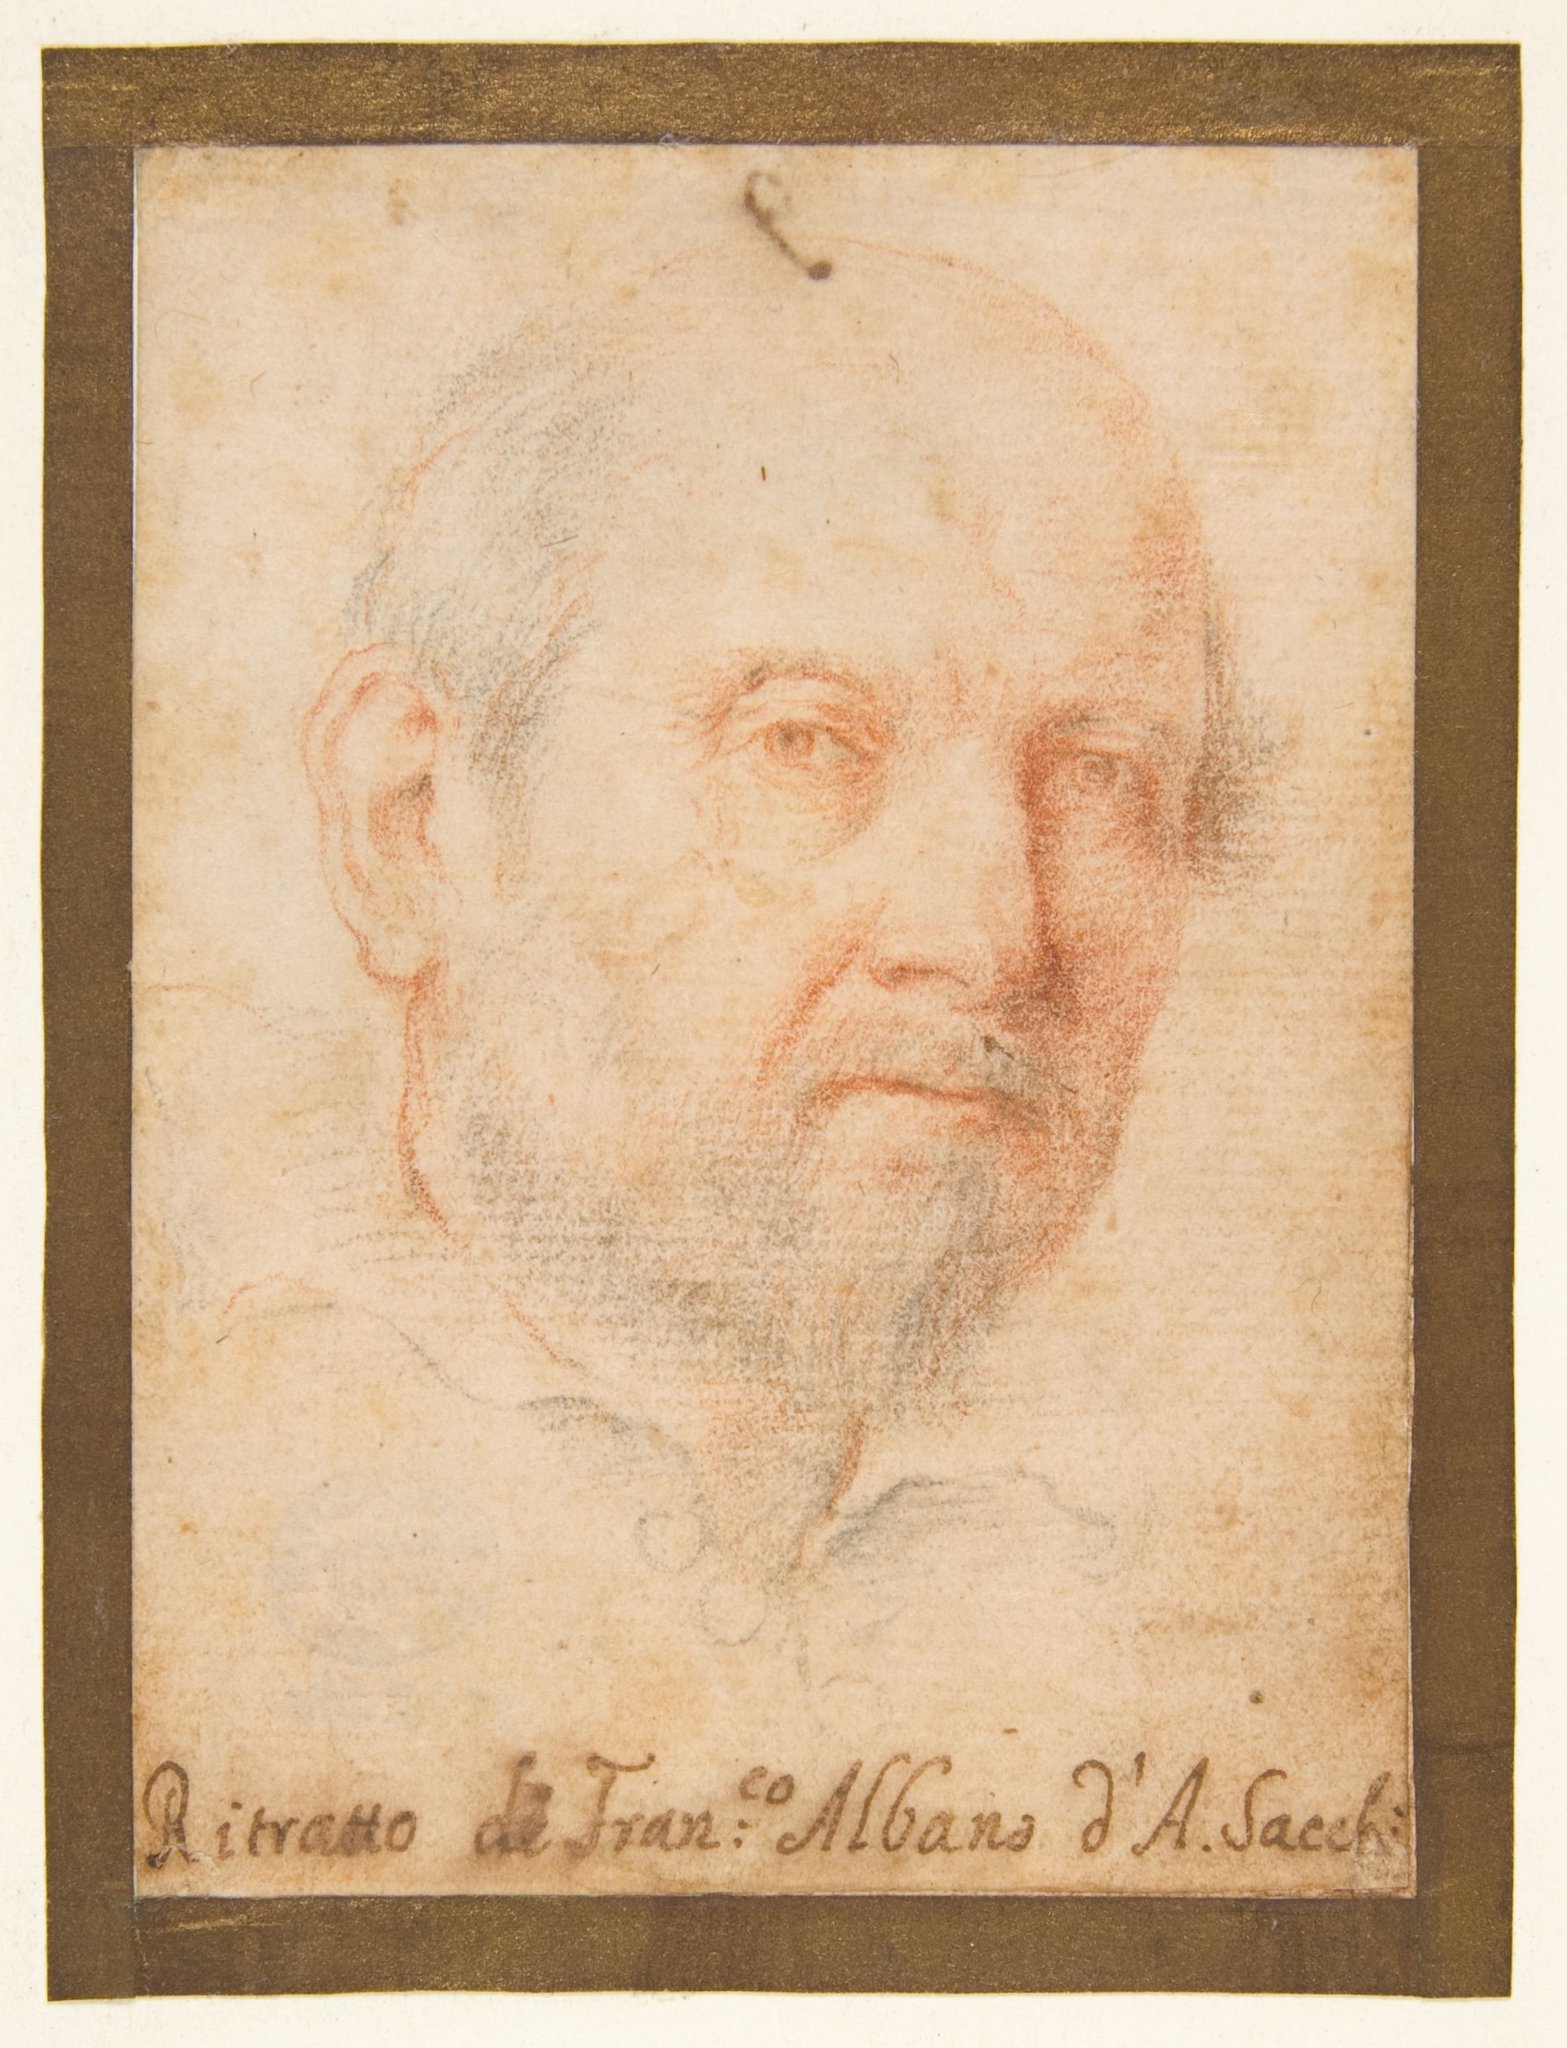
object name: drawing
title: Portrait of a Man: Francesco Albani ?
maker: andrea sacchi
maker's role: artist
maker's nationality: italian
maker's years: 1599-1661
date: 1599-1661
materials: chalk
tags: men,portraits